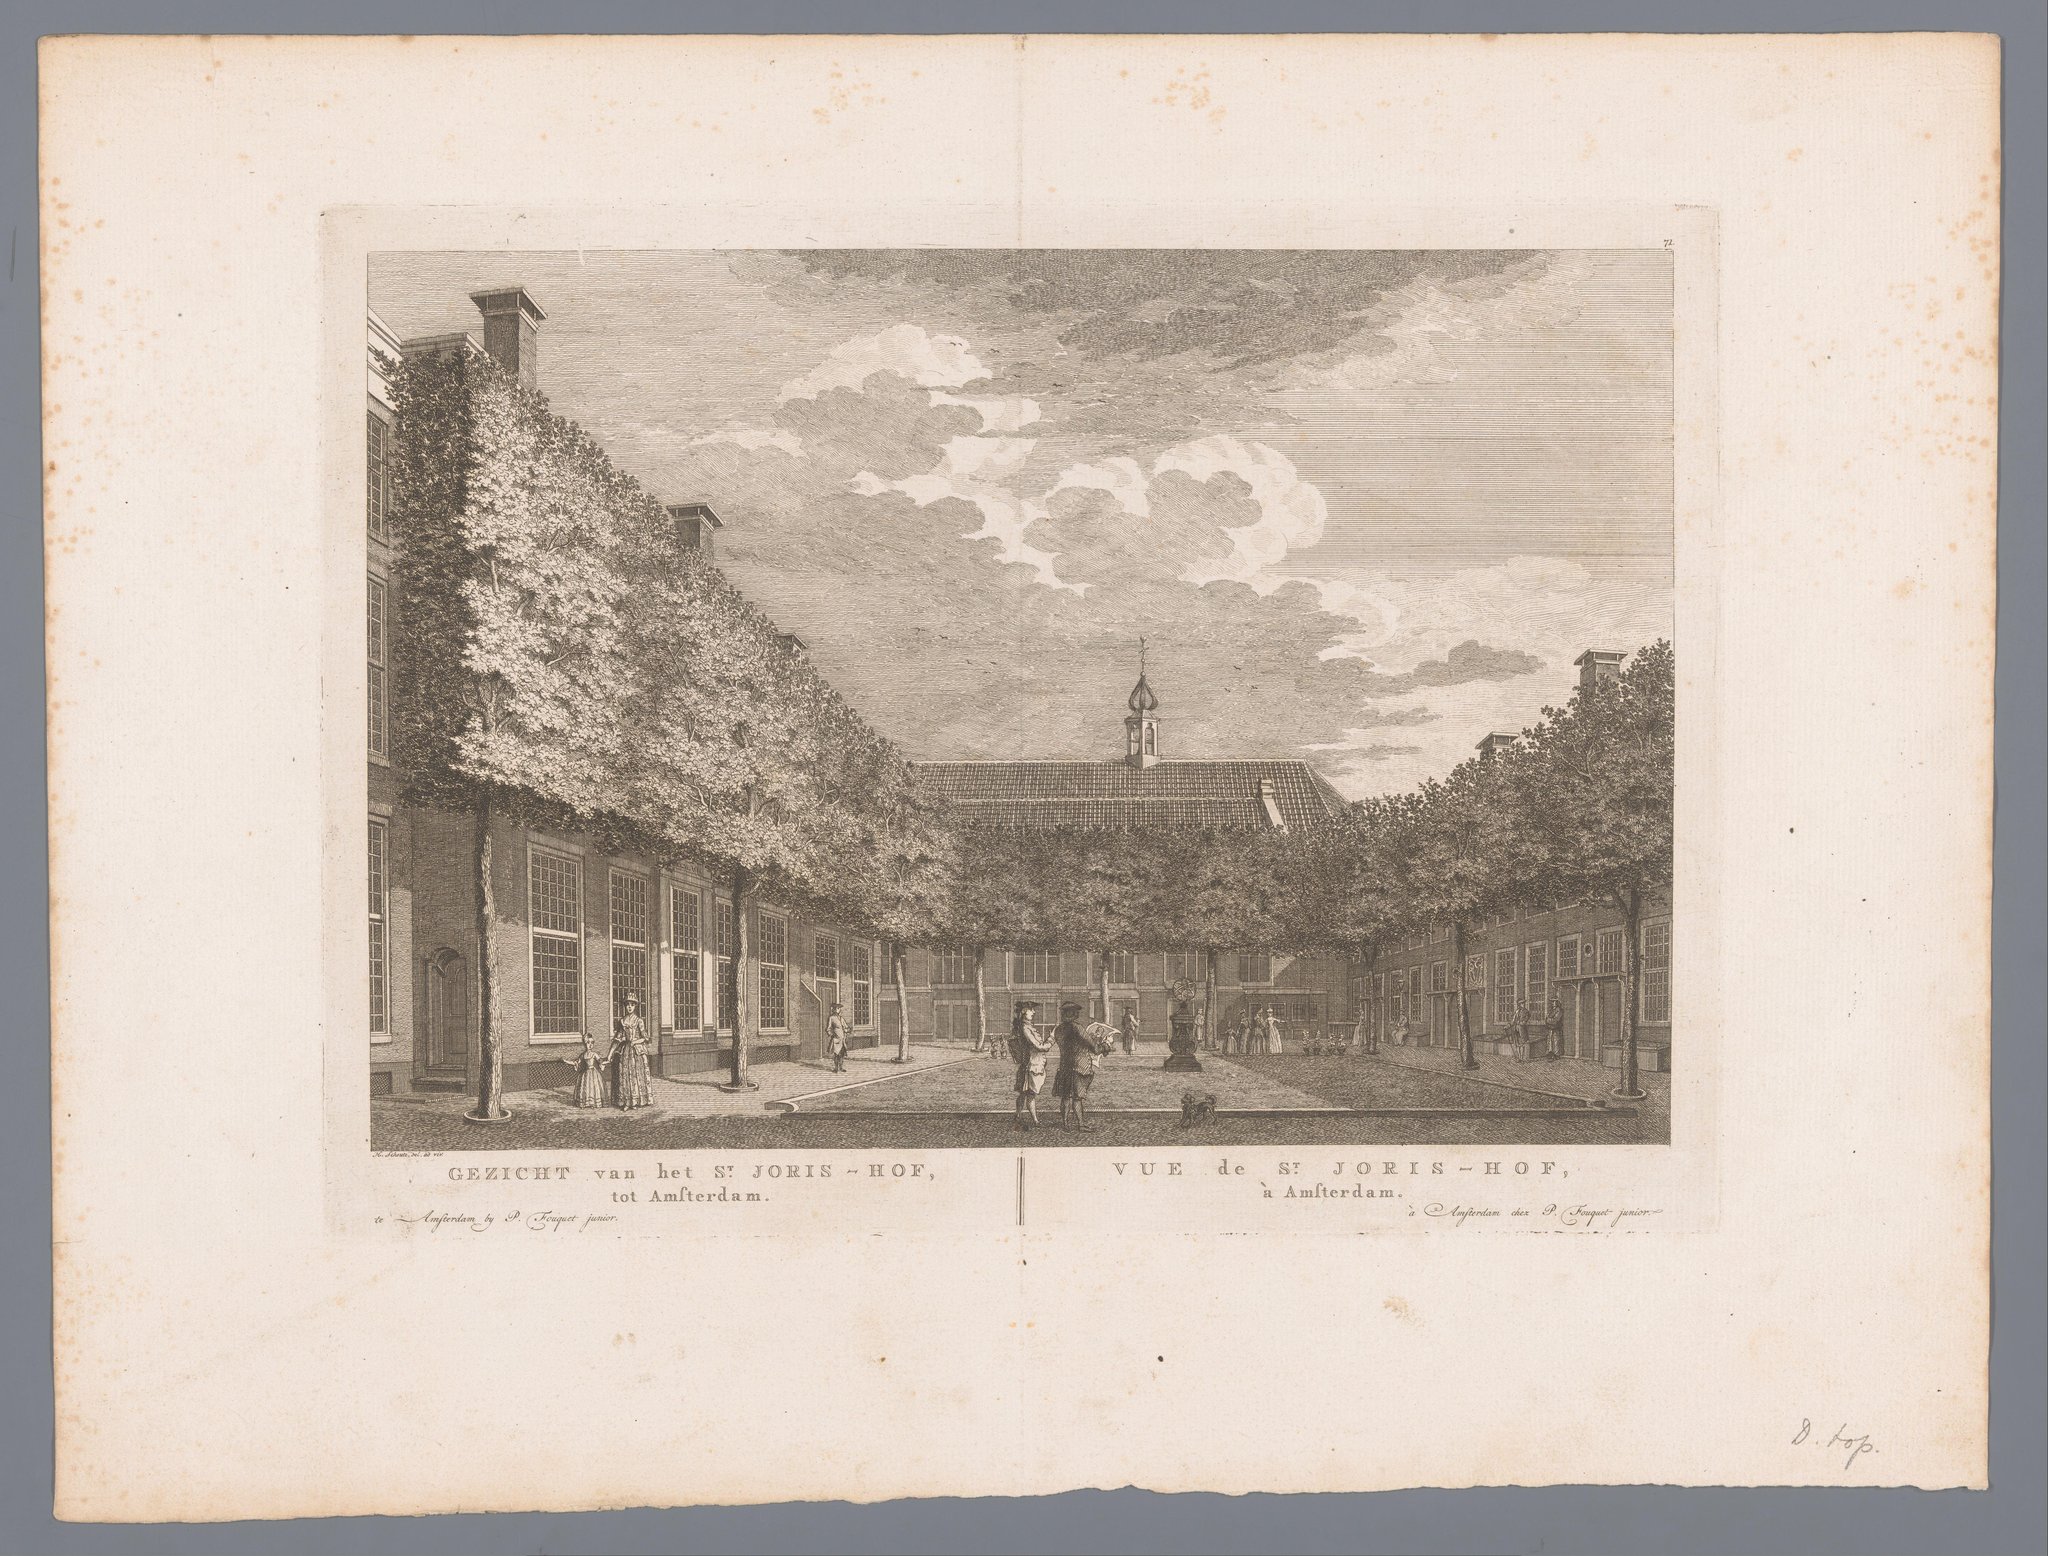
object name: book illustration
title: Gezicht van het St. Joris-hof, tot Amsterdam / Vue de St. Joris-hof, à Amsterdam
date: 1778-1783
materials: paper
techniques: engraving, etching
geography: amsterdam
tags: alms-house (dutch: 'hofje')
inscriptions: collector's mark: Lugt 2228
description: Prent uit een van de edities van de Atlas Fouquet: Afbeeldingen van de wyd-vermaarde koopstad Amsterdam benevens des zelvs voornaamste gebouwen en gezigten alle naar het leeven getekend / Receuil des edifices les plus considerables et des plus belles vues, de la fameuse ville d'Amsterdam, dessinées d'après nature. Amsterdam: Pierre Fouquet, 1778-1783. En: Nieuwe atlas, van de voornaamste gebouwen en gezigten der stad Amsterdam, met derzelver beknopte beschryvingen. 2 dln. Amsterdam: Daniël Jean Changuion en Petrus den Hengst [in opdracht van Pierre Fouquet], 1783. Later ook gebruikt in: Nieuwe atlas, van de voornaamste gebouwen en gezigten der stad Amsterdam. Met derzelver beknopte beschryvingen. Amsterdam: Evert Maaskamp, 1805.